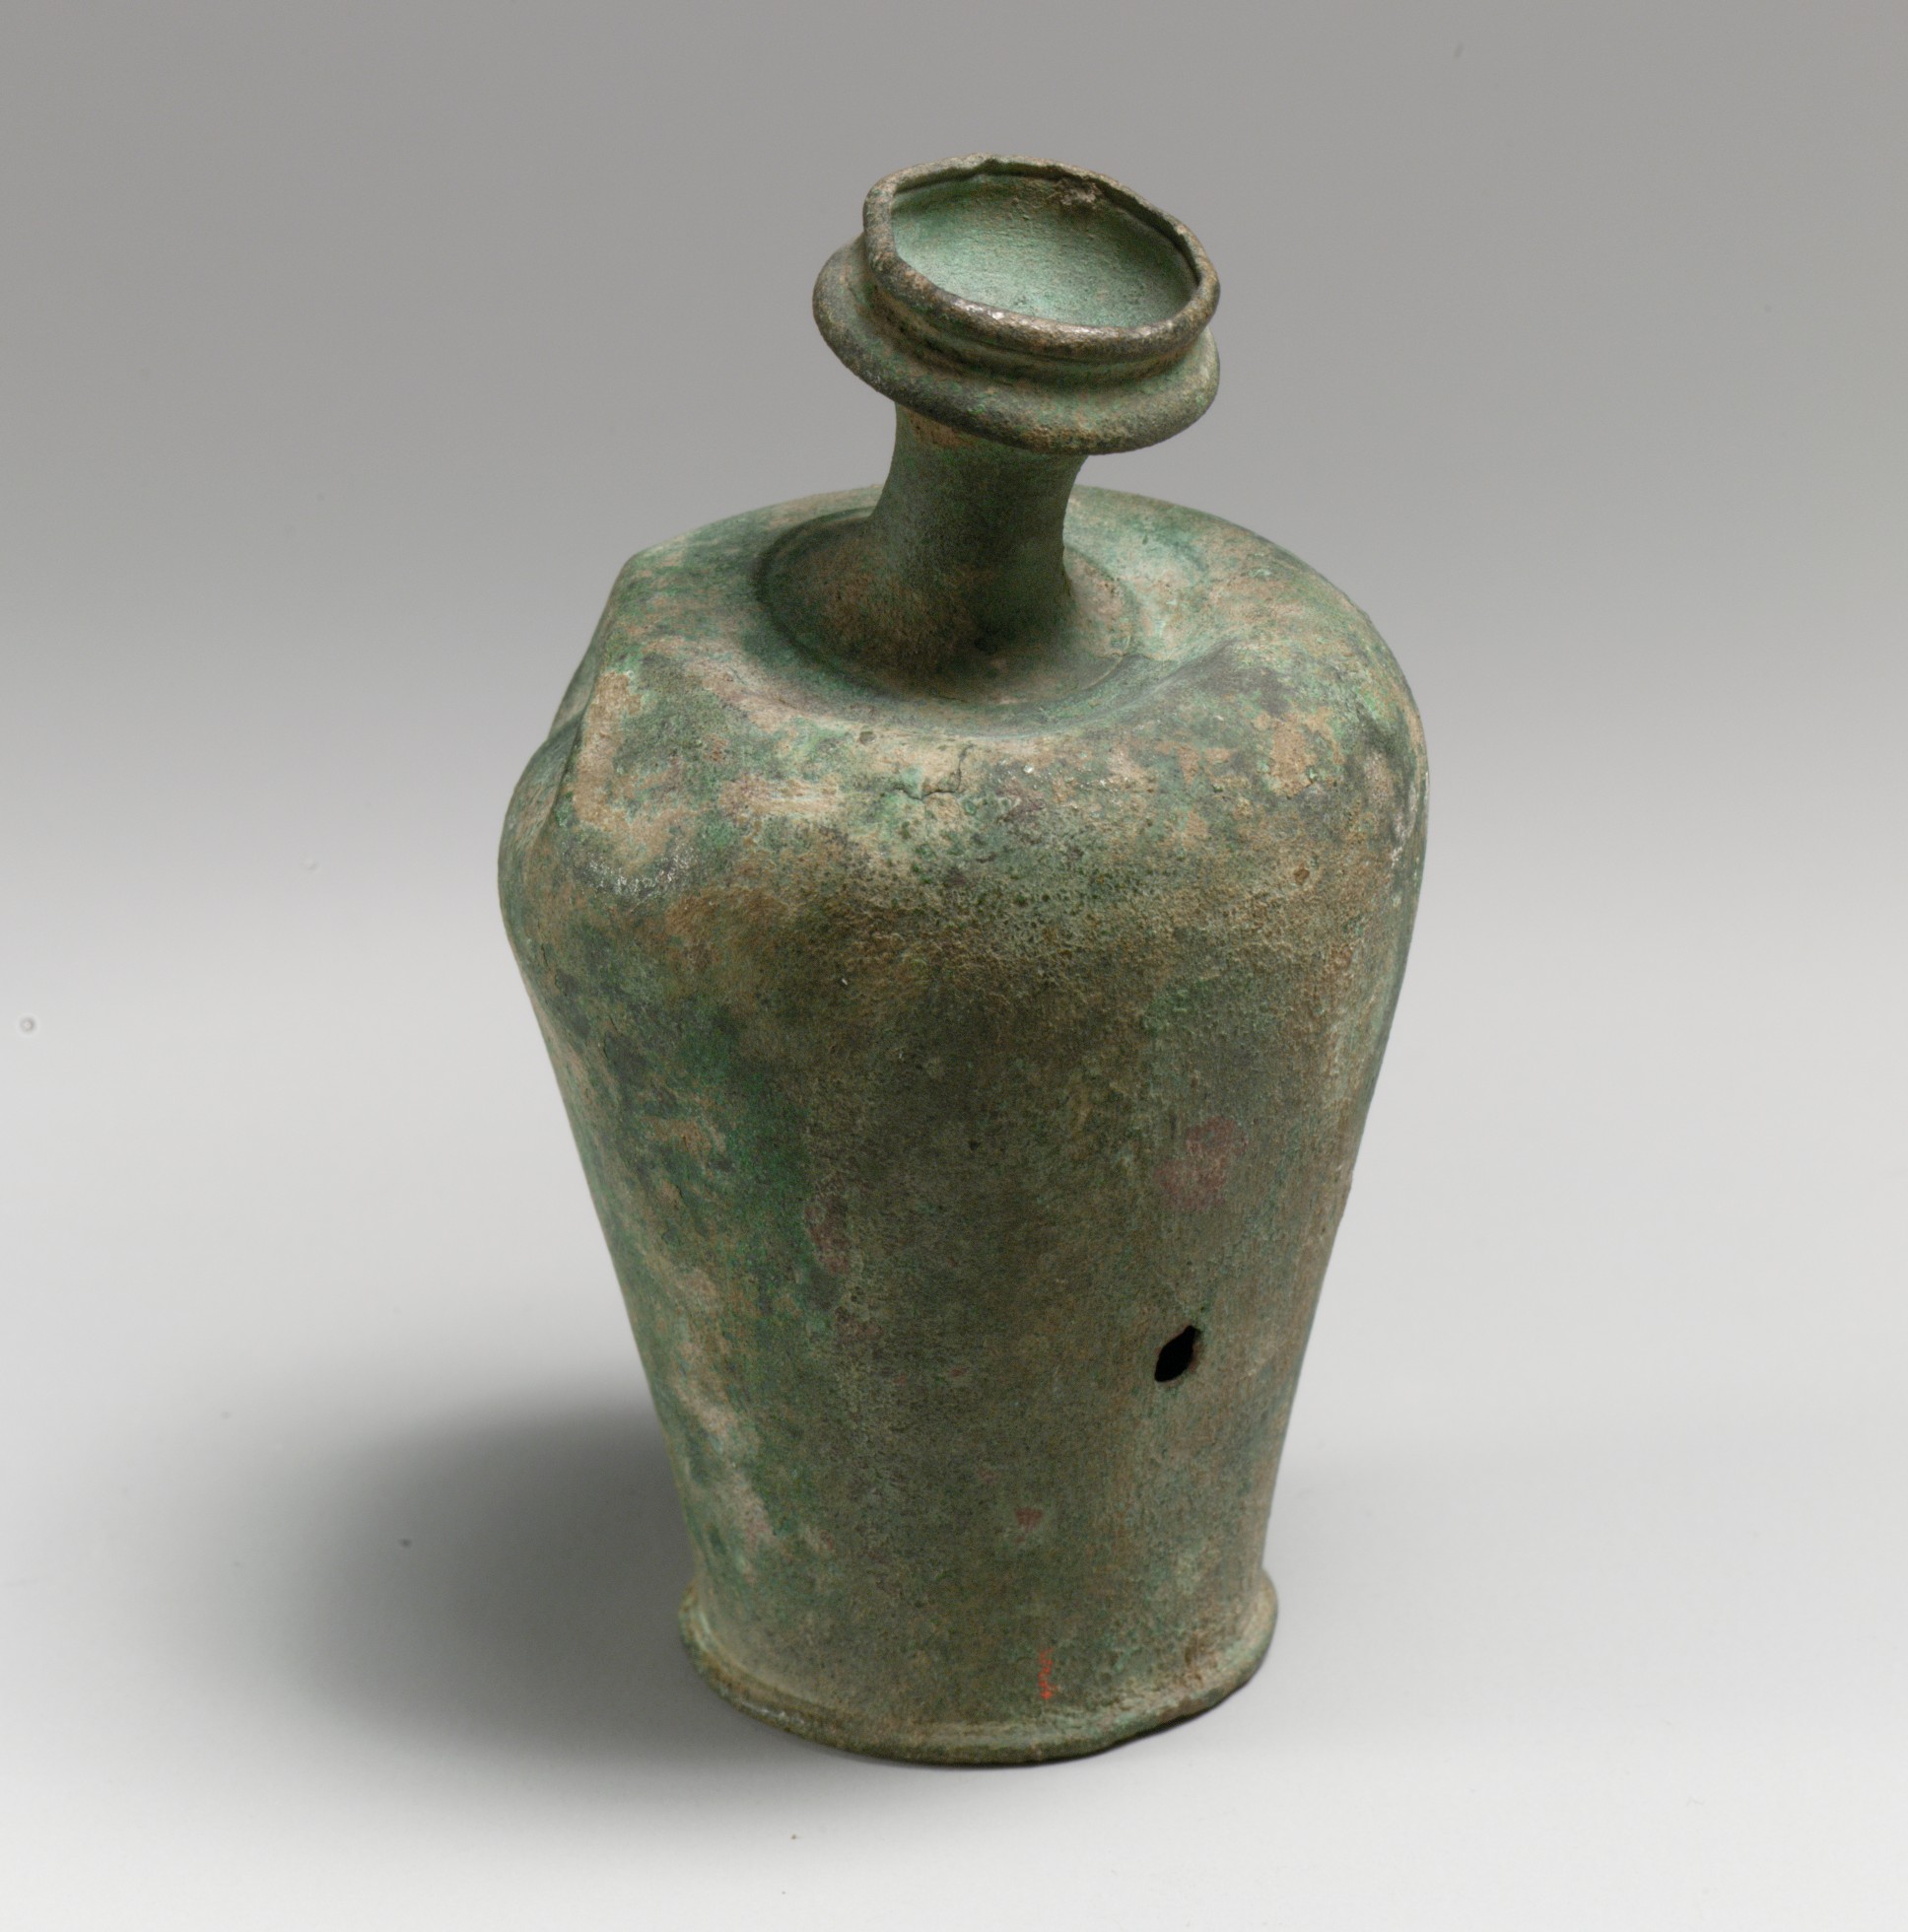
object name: bottle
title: Bronze aryballos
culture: roman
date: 1-200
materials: bronze